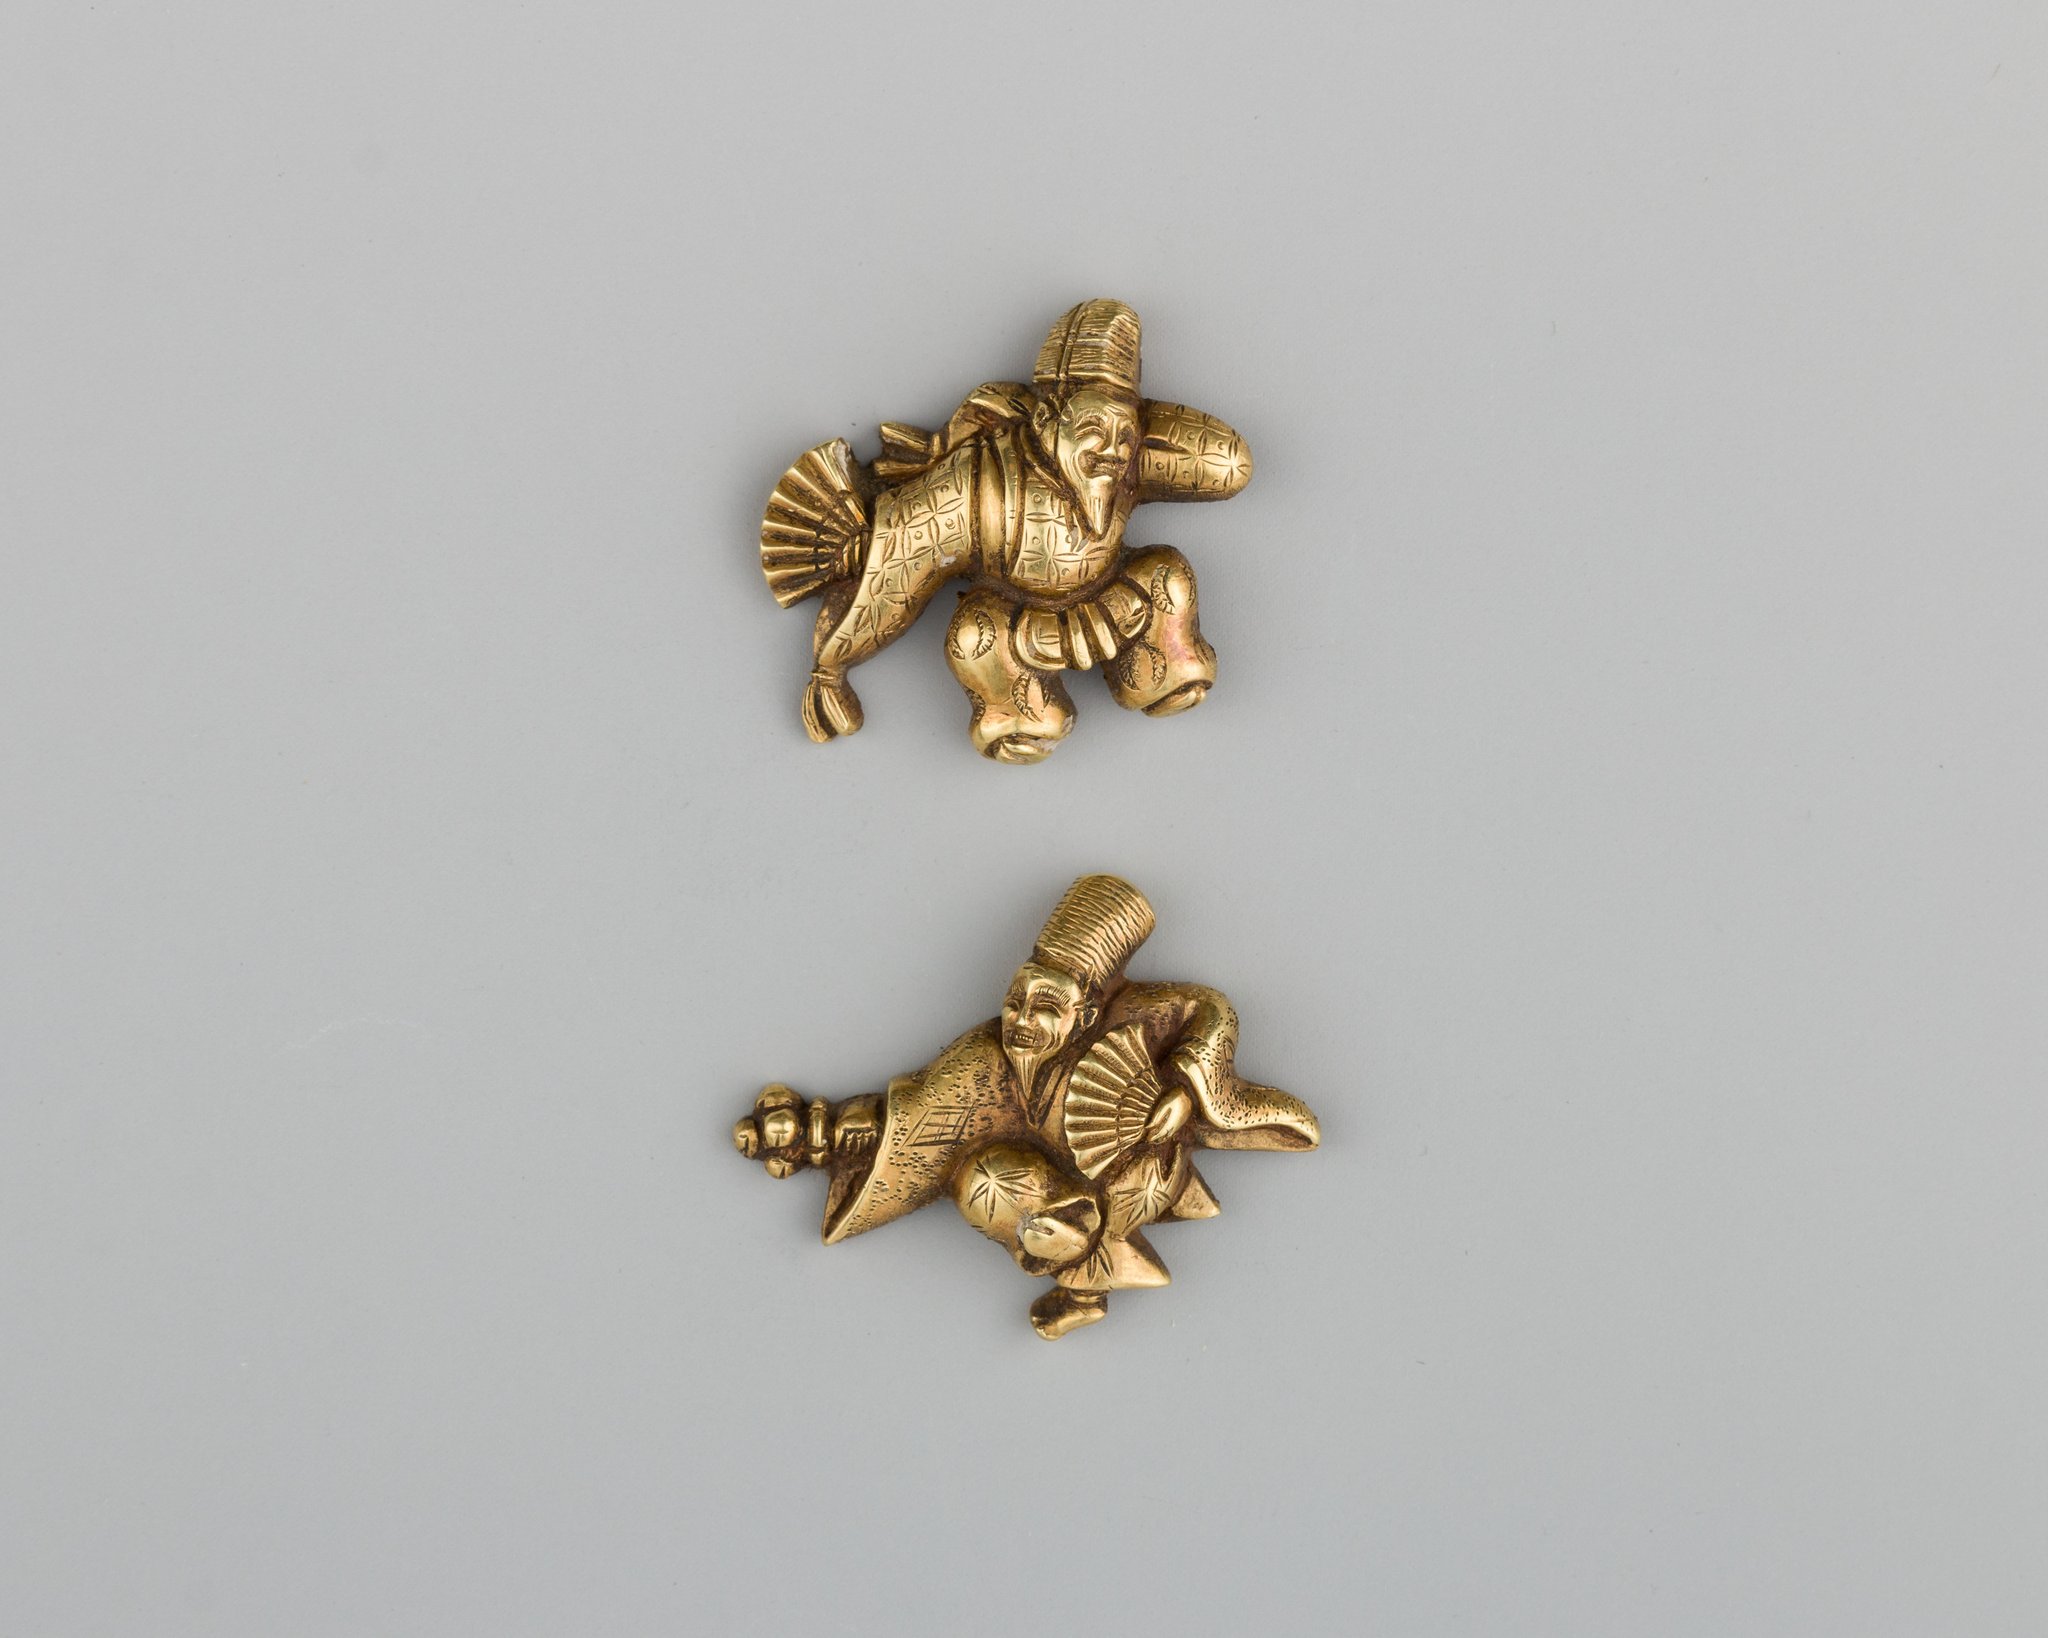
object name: pair of sword grip ornament menuki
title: Pair of Sword-Grip Ornaments (Menuki)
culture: japanese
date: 1567-1633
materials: gold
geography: japan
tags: fans,men